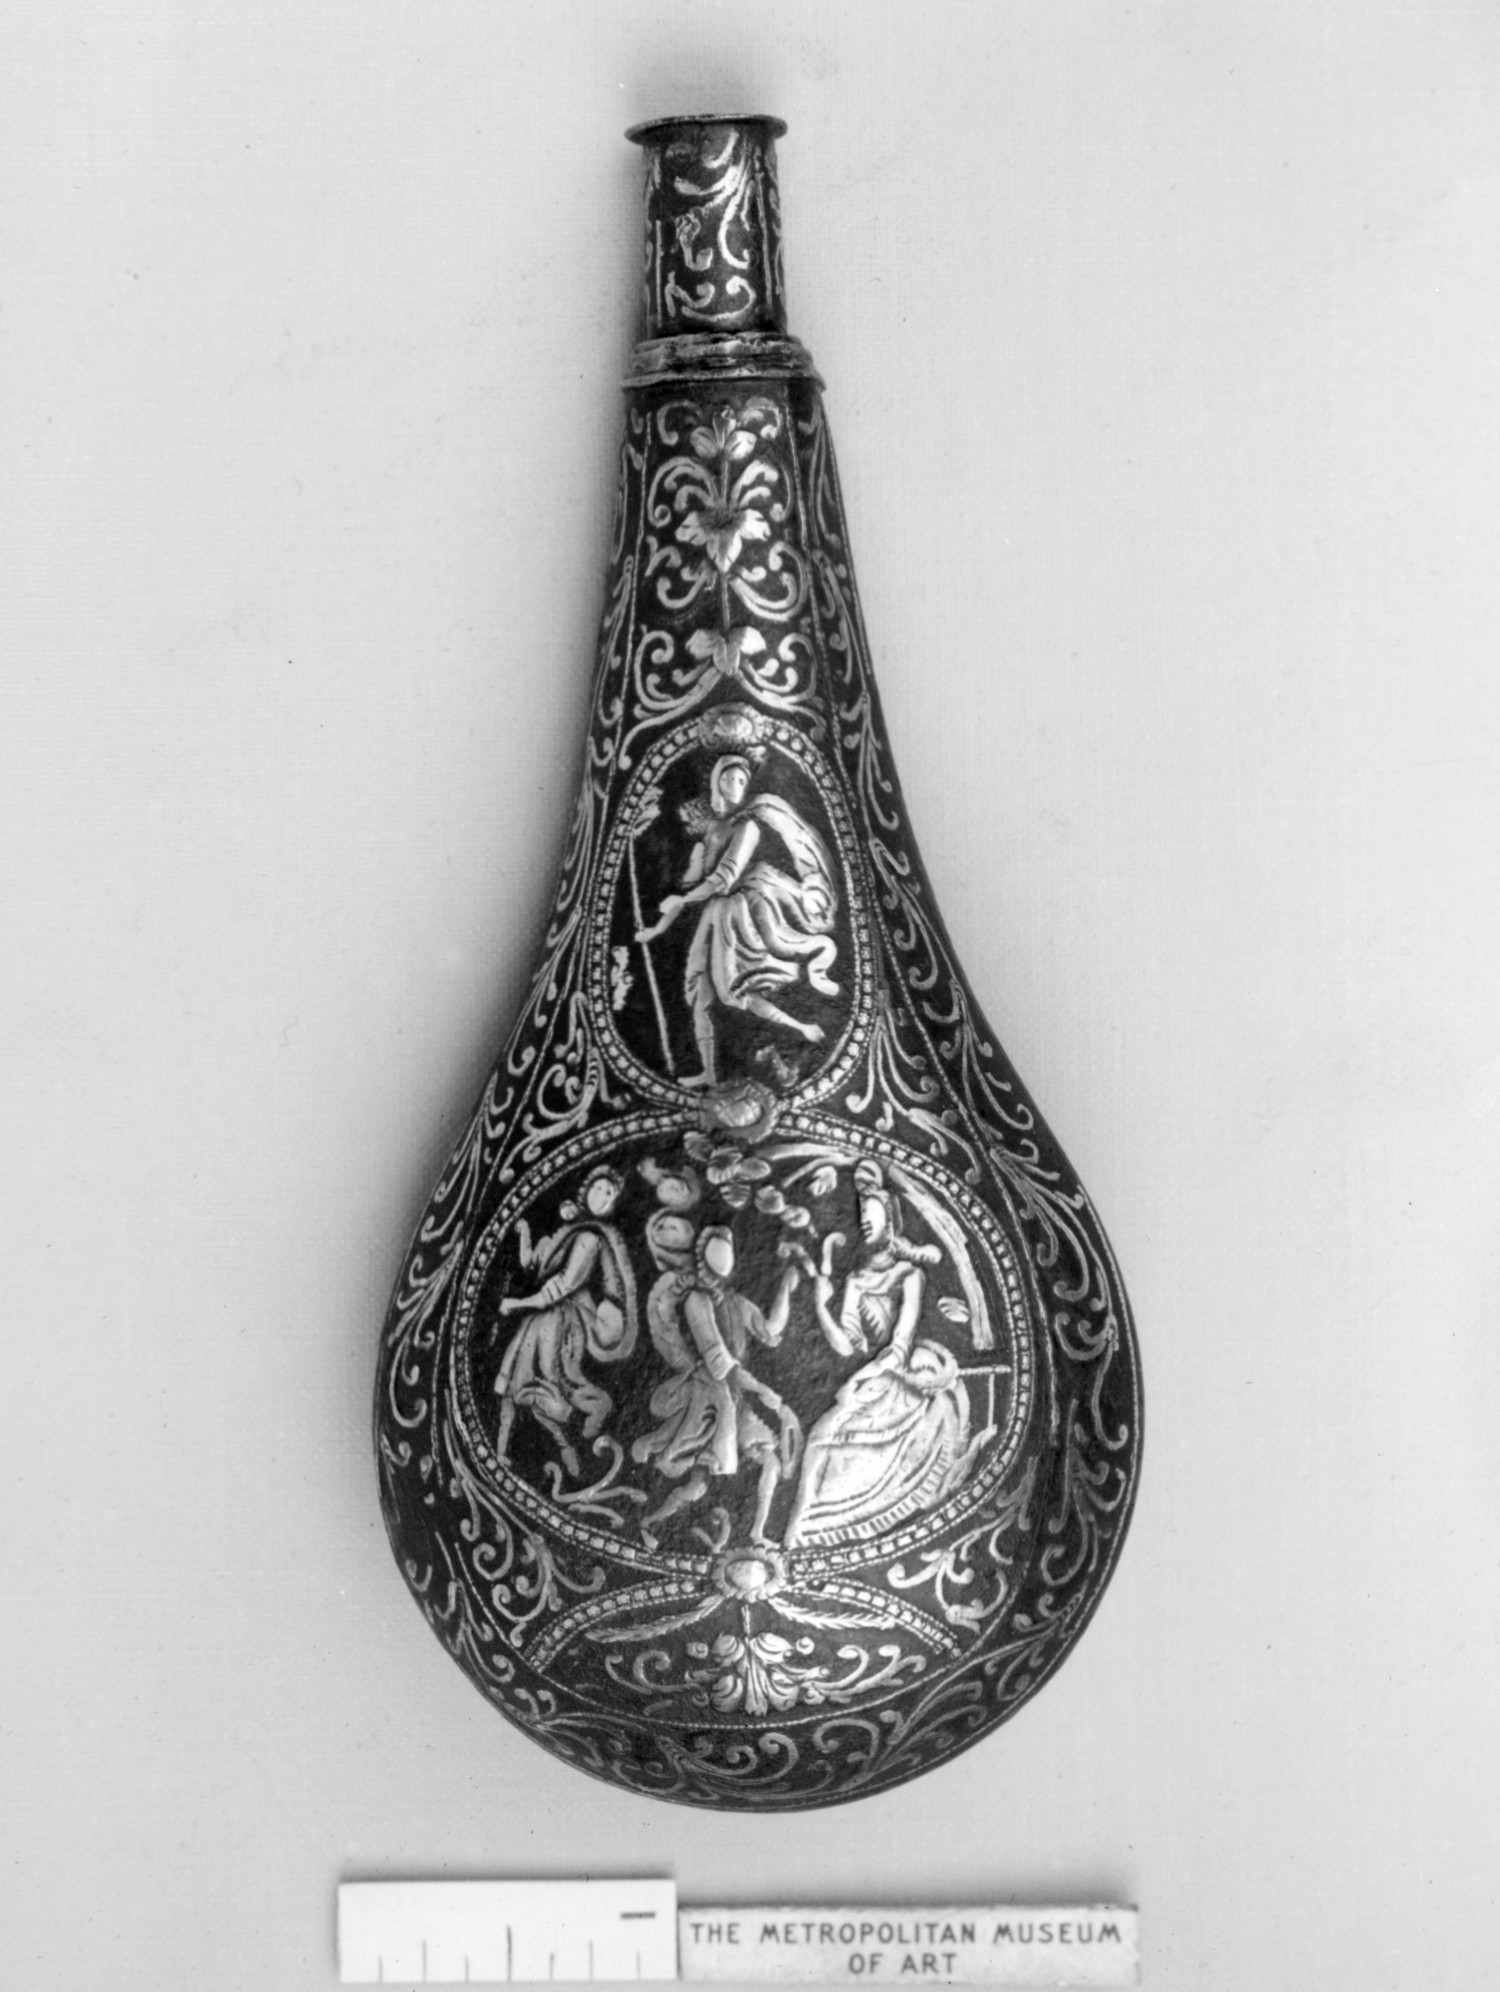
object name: snuff bottle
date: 1690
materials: iron